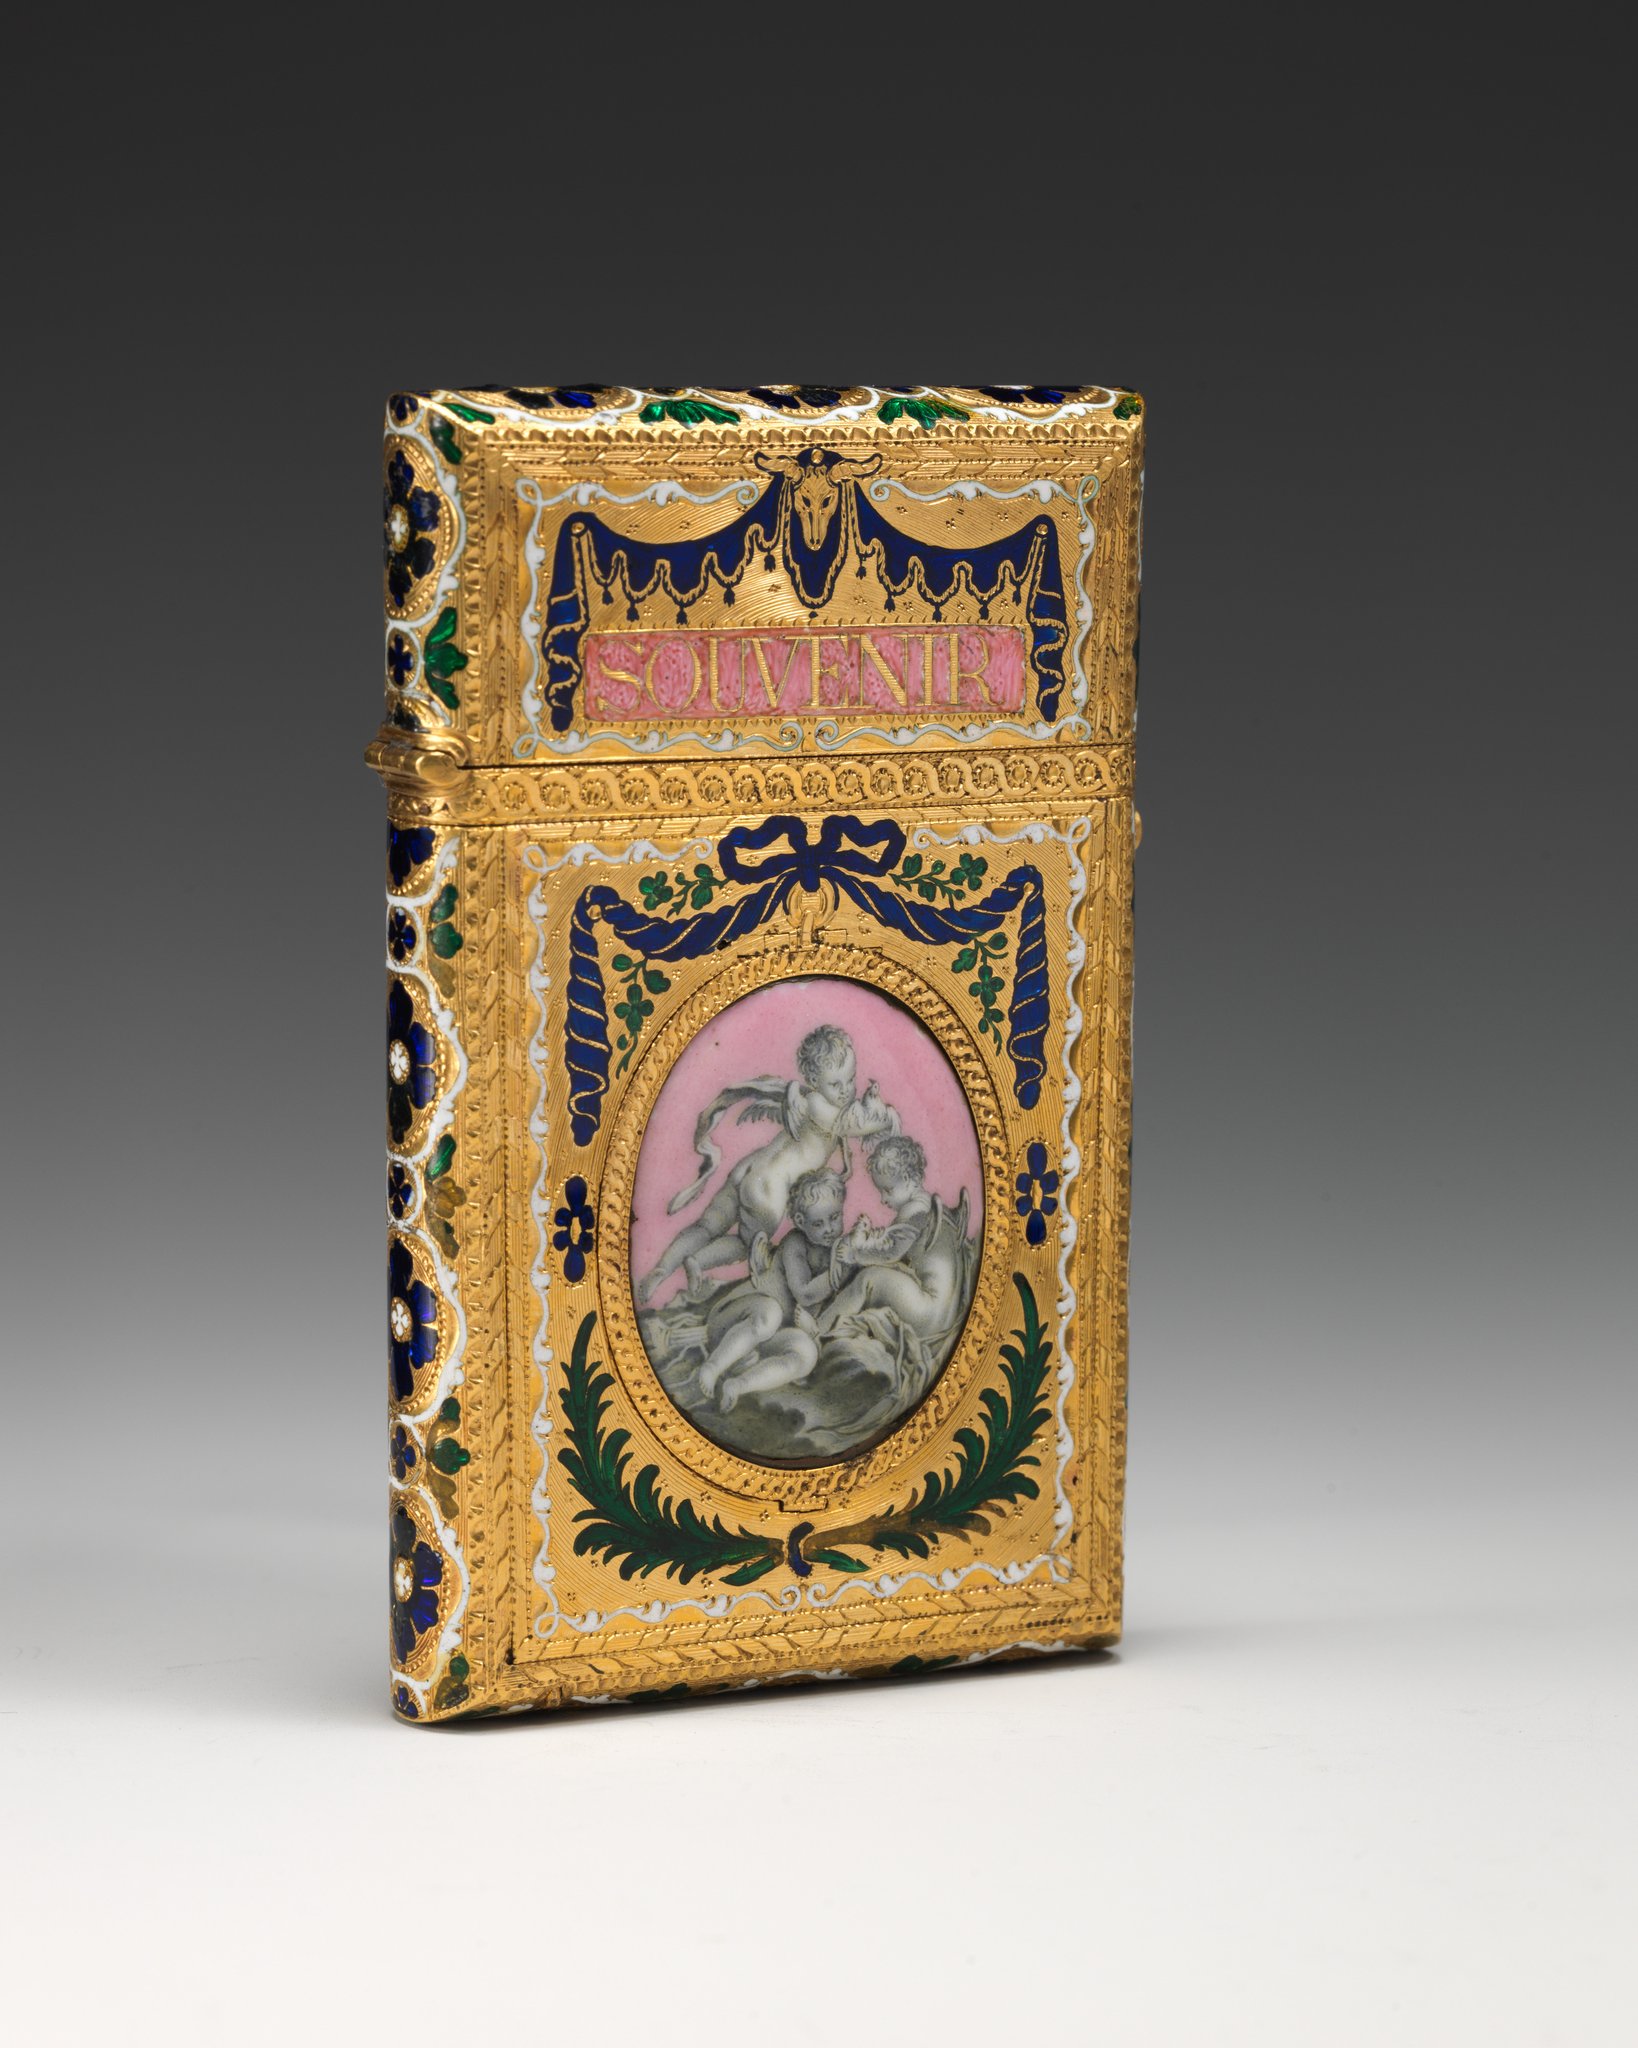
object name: souvenir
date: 1770-1780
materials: enamel, gold, ivory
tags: cupid